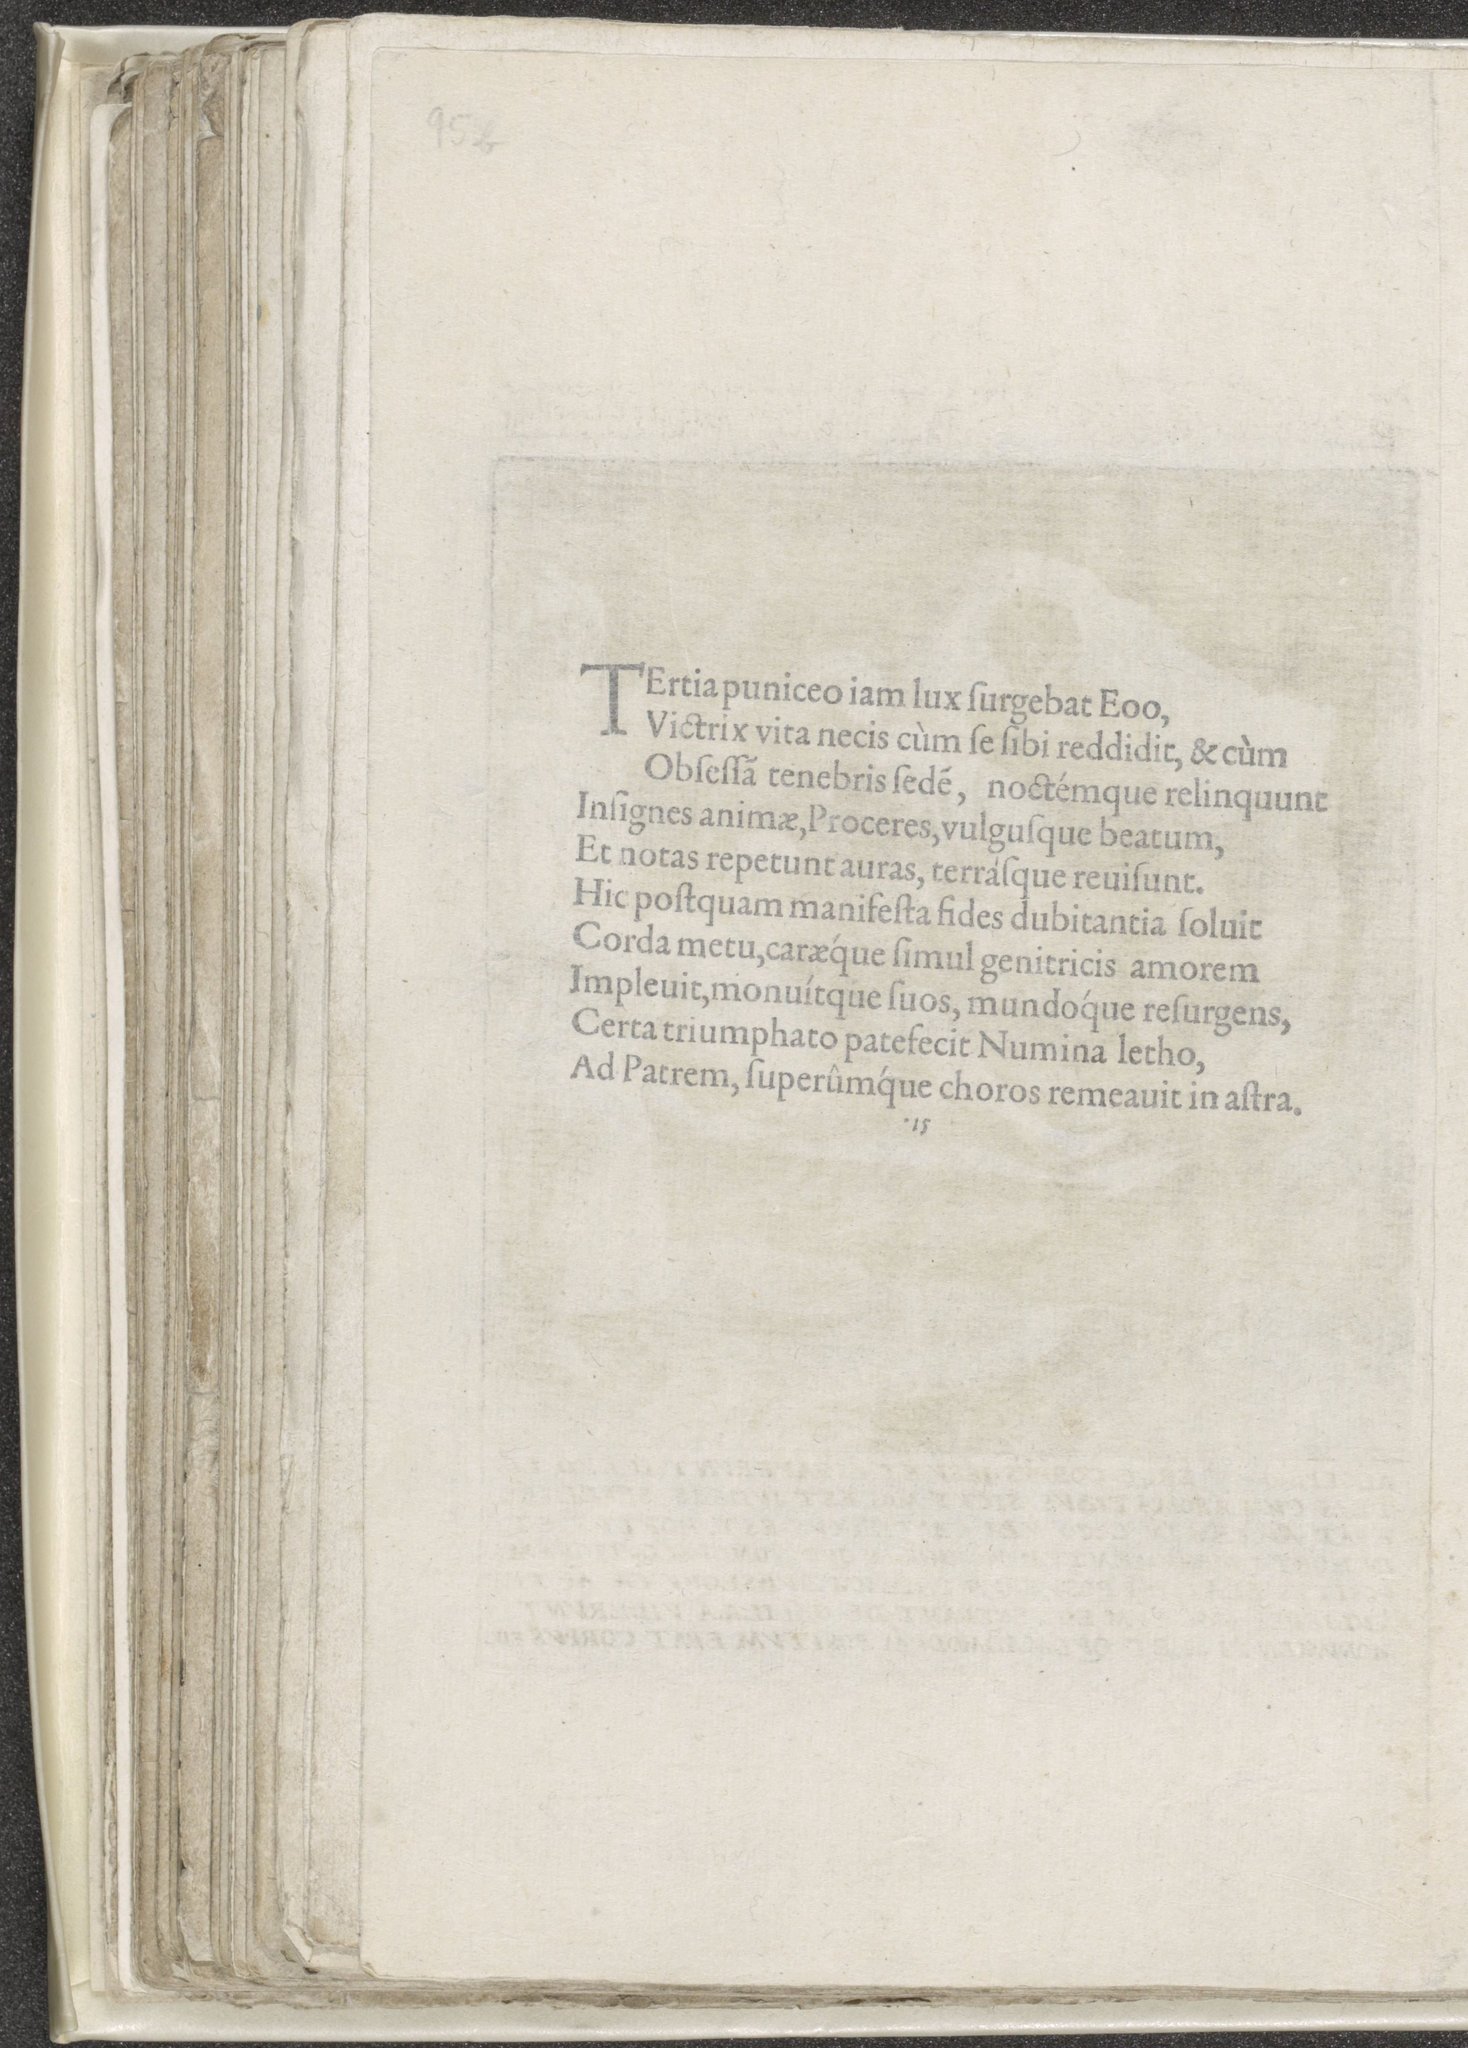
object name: album leaf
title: Tekst over de Opstanding van Christus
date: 1572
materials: paper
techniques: letterpress printing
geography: antwerp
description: Tijdens de restauratie in 1988 bleek dat op de achterzijde van de prenten van de Passie-serie van Wierix Latijnse teksten in boekdruk staan. Deze vormen, wanneer op de juiste wijze in boekvorm gebonden (wat nu in het Heemskerck-album niet het geval is), een toelichting op de passievoorstellingen. Om de teksten zichtbaar te laten zijn de prenten bij de restauratie niet meer met de achterzijde op elkaar geplakt.